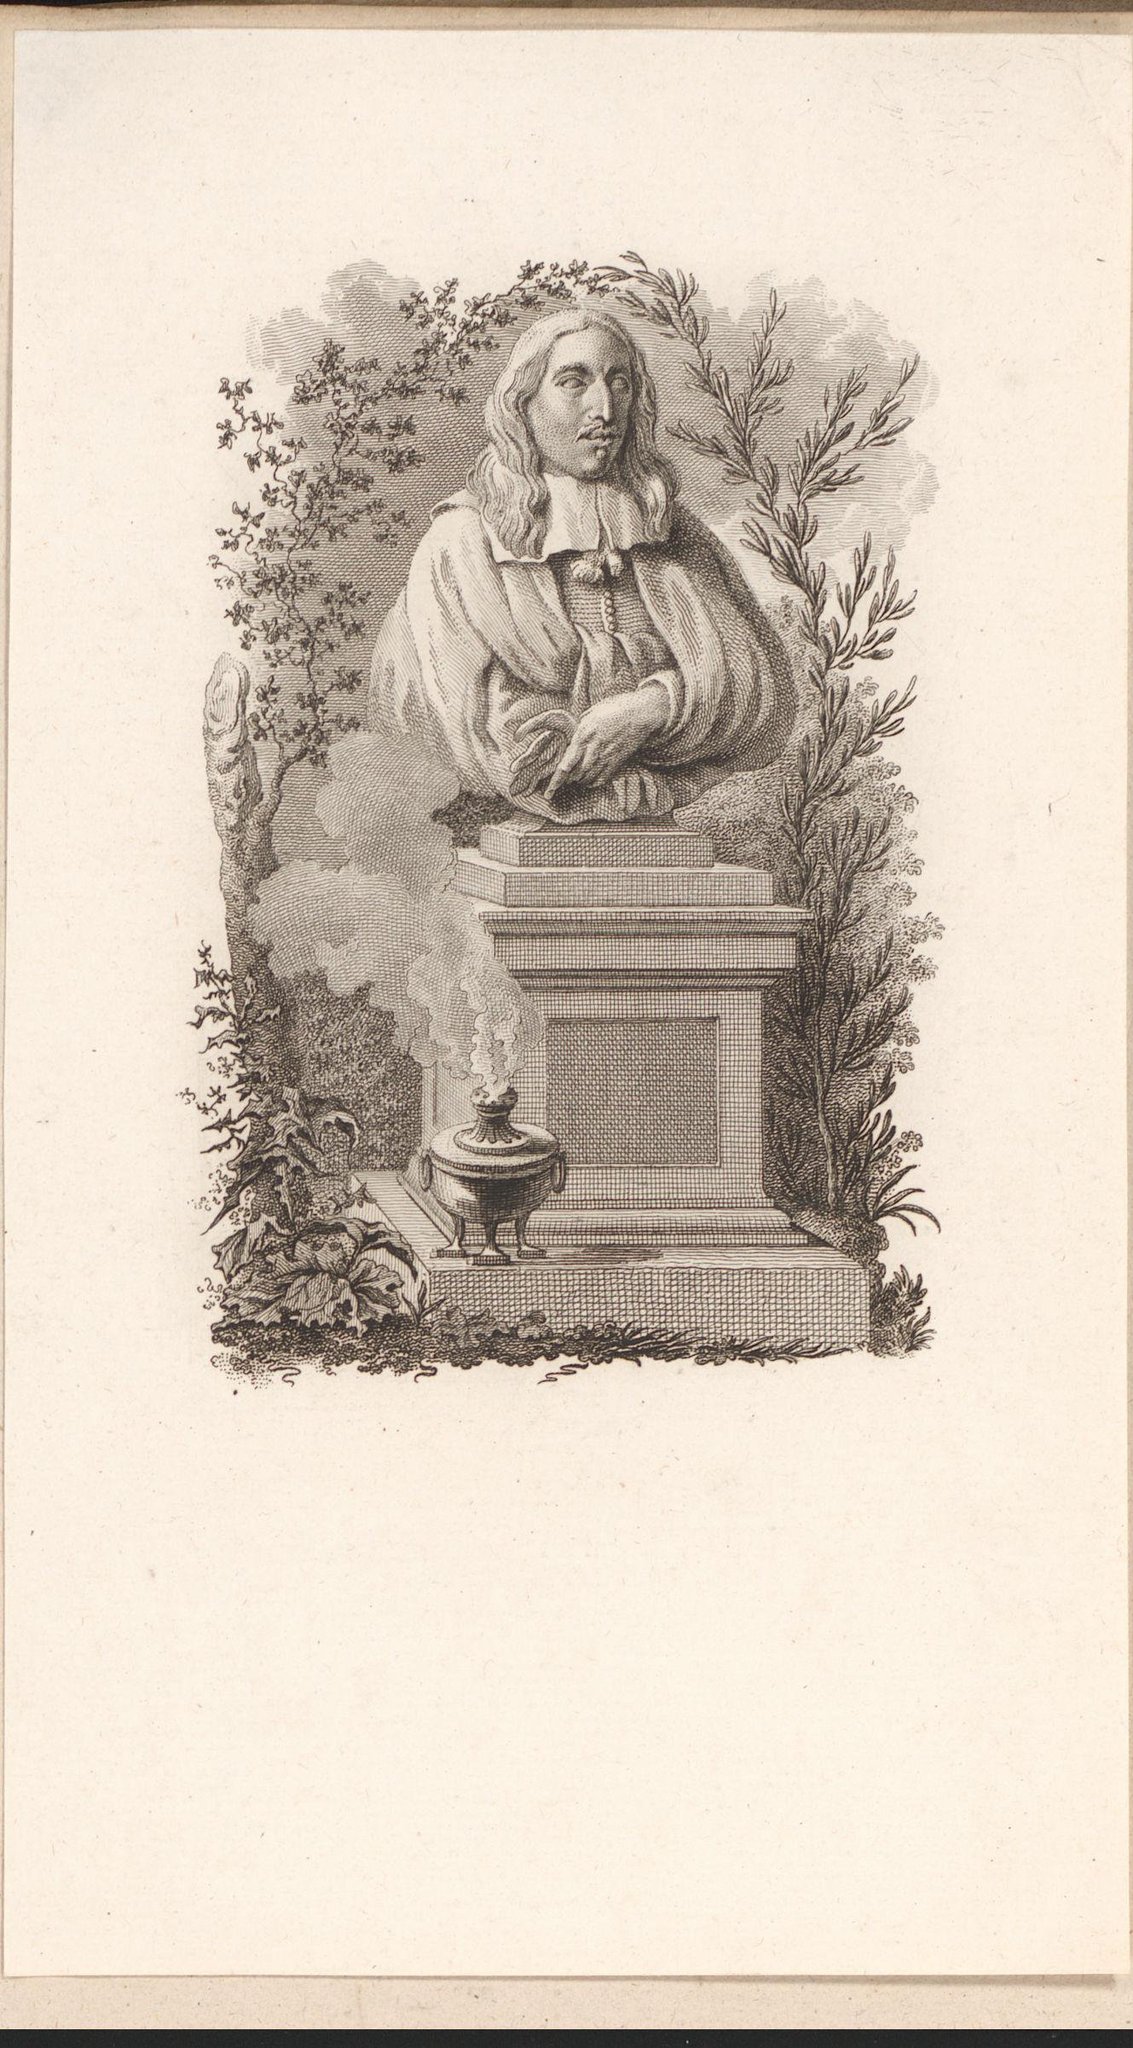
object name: titelblad, titelpagina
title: Buste van Johan de Witt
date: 1805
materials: paper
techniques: engraving, etching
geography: amsterdam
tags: johan de witt, historical persons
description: Proefdruk van een titelpagina gebruikt voor: Loosjes Pietersz., Adriaan. Johan de Witt. Raadpensionaris van Holland. Haarlem: A. Loosjes, 1805.